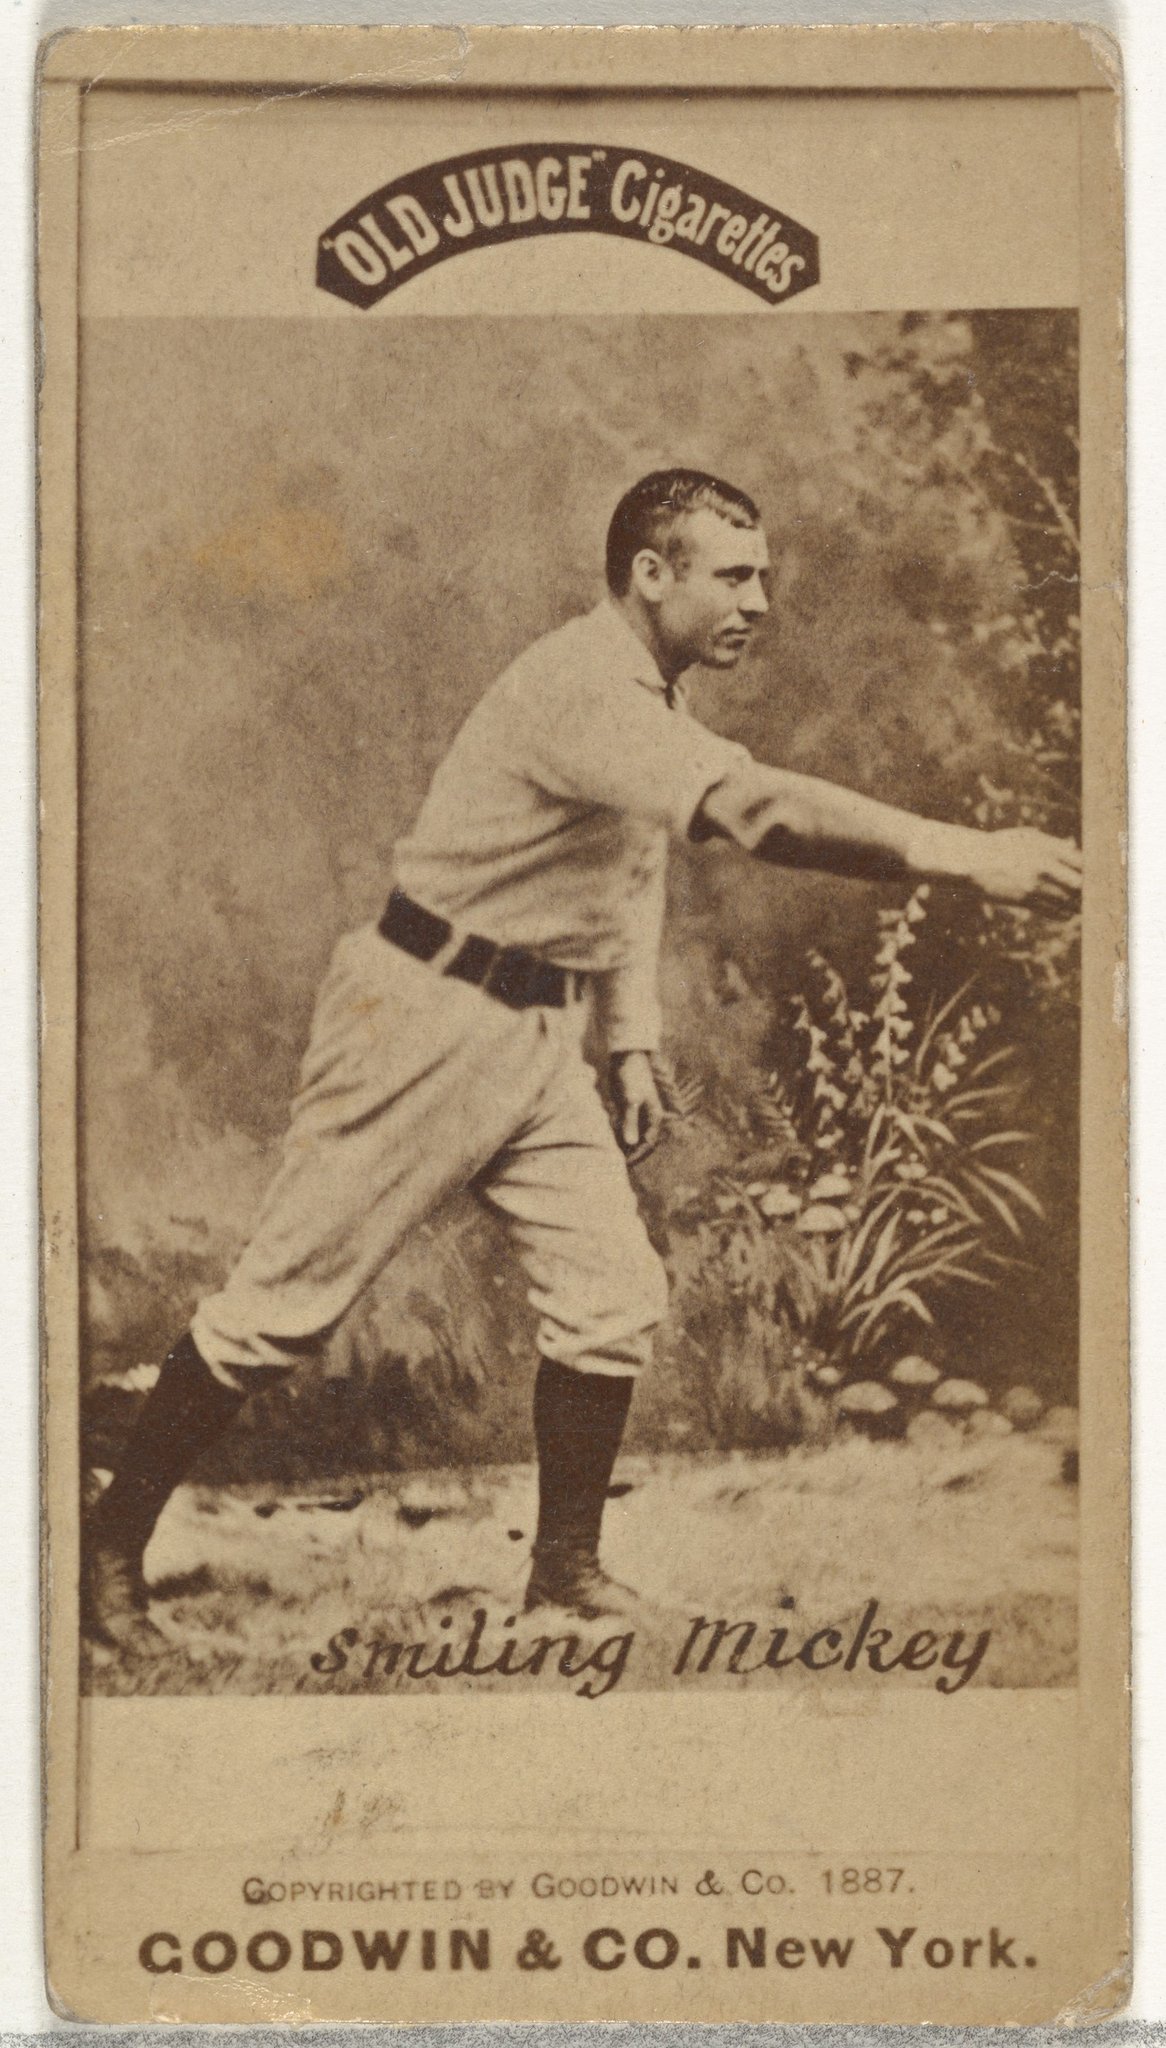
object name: baseball card, photograph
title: Michael Francis "Smiling Mickey" Welch, from the Old Judge series (N172) for Old Judge Cigarettes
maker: goodwin & company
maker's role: publisher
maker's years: 1850-1950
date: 1887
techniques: albumen silver print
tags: men,portraits,baseball,athletes